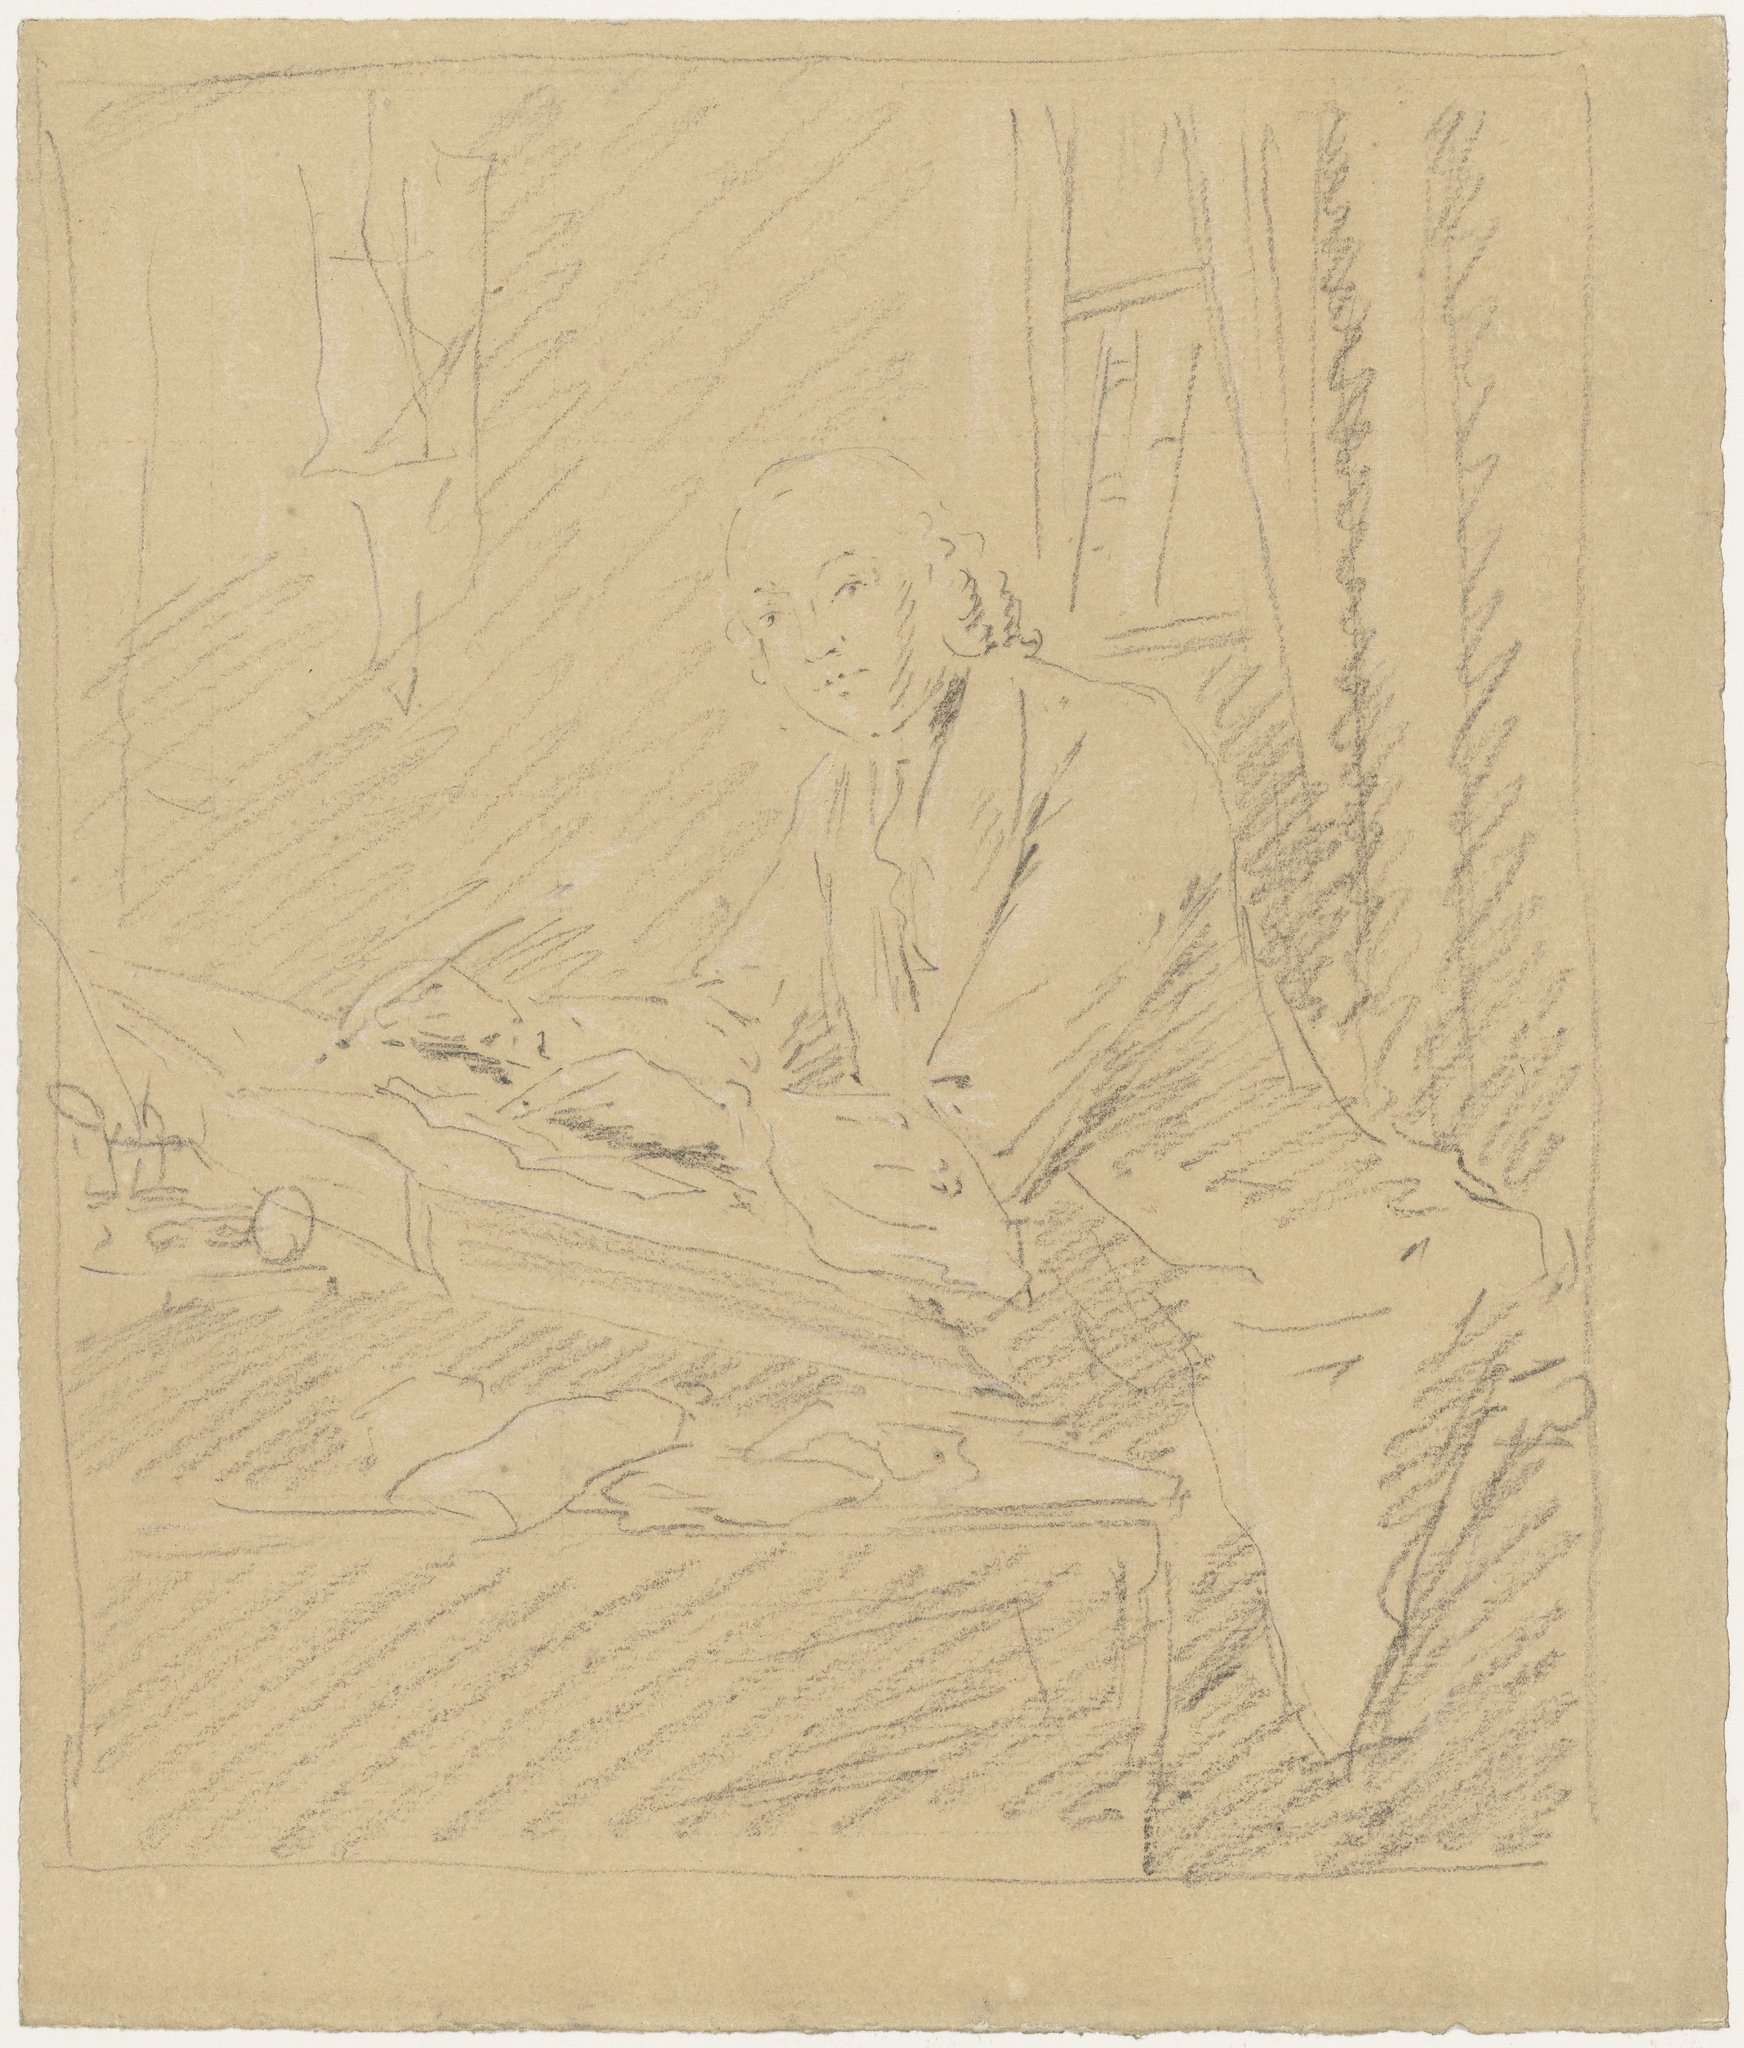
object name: drawing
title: Schets voor een portret van een schrijvende man in een interieur, driekwart naar links (C. Ploos van Amstel?)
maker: Anonymous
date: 1700-1800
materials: chalk, paper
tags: anonymous historical person portrayed alone, study; 'studiolo'; library